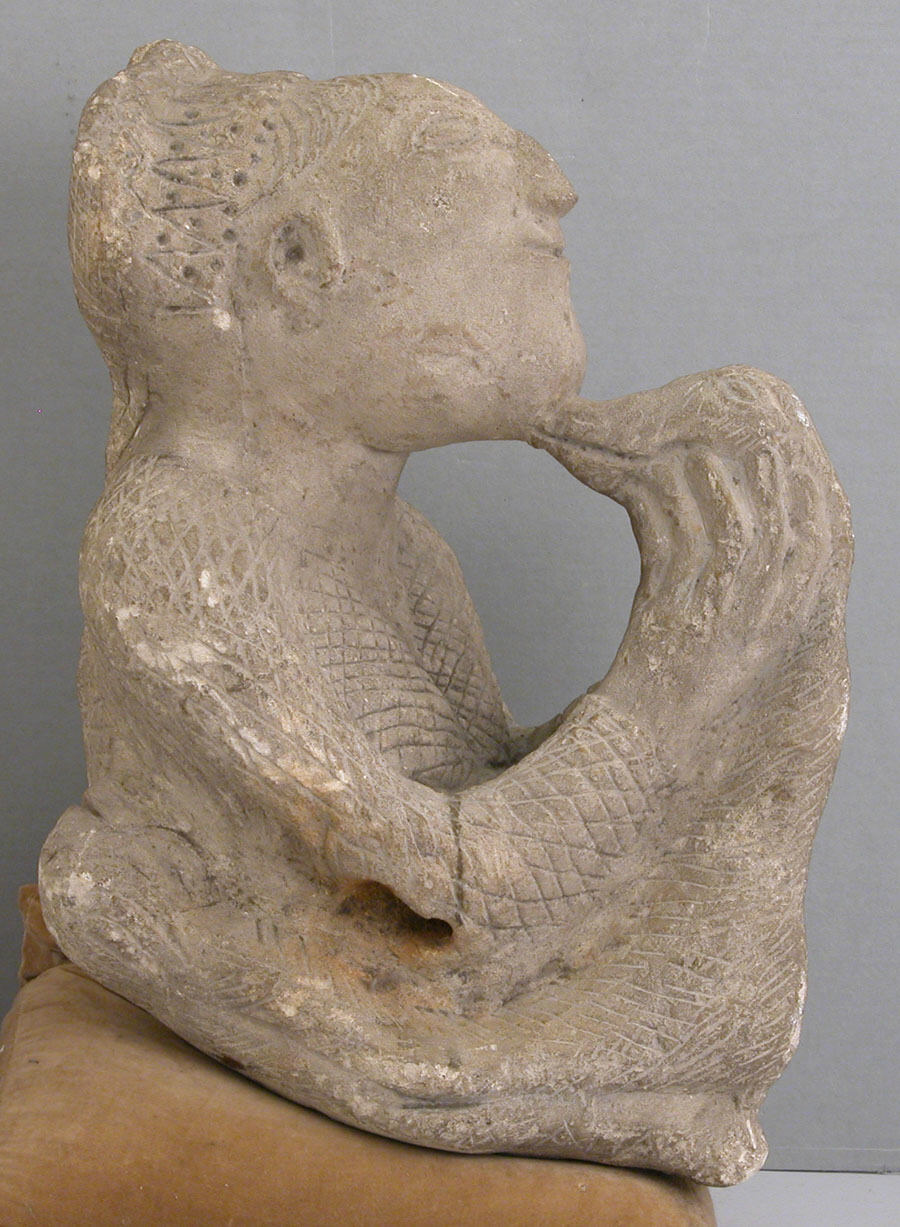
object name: figure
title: Grotesque Figure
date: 201-1200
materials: stone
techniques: carving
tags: human figures